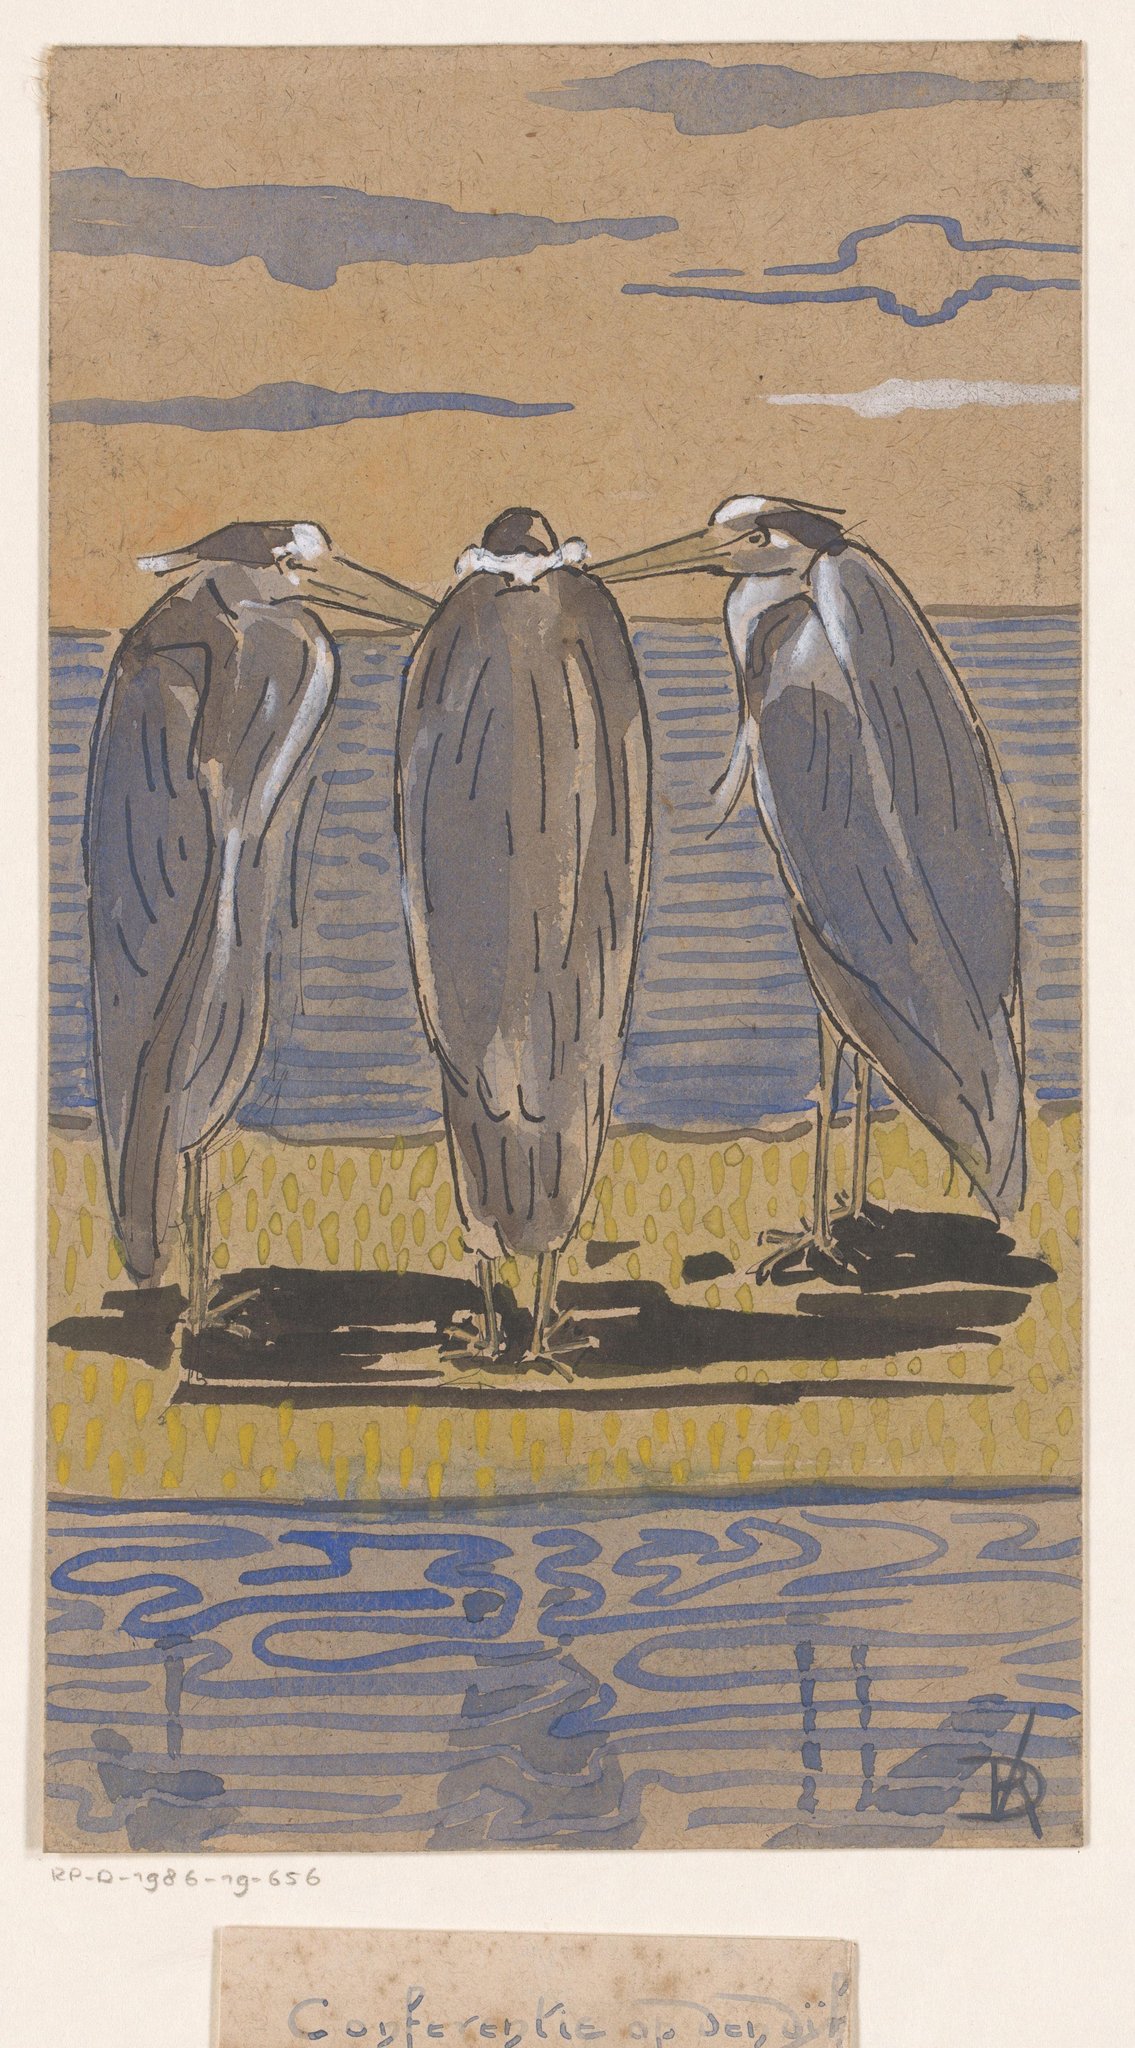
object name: drawing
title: Drie reigers op een dijk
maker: reinier willem petrus de vries (1874-1953)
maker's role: draughtsman, print maker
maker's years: 1874-1953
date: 1884-1952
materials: paint, ink, paper, watercolor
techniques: brush, pen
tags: shore-birds and wading-birds: heron, dikes, levee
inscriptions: collector's mark: ‘R:MVS.’